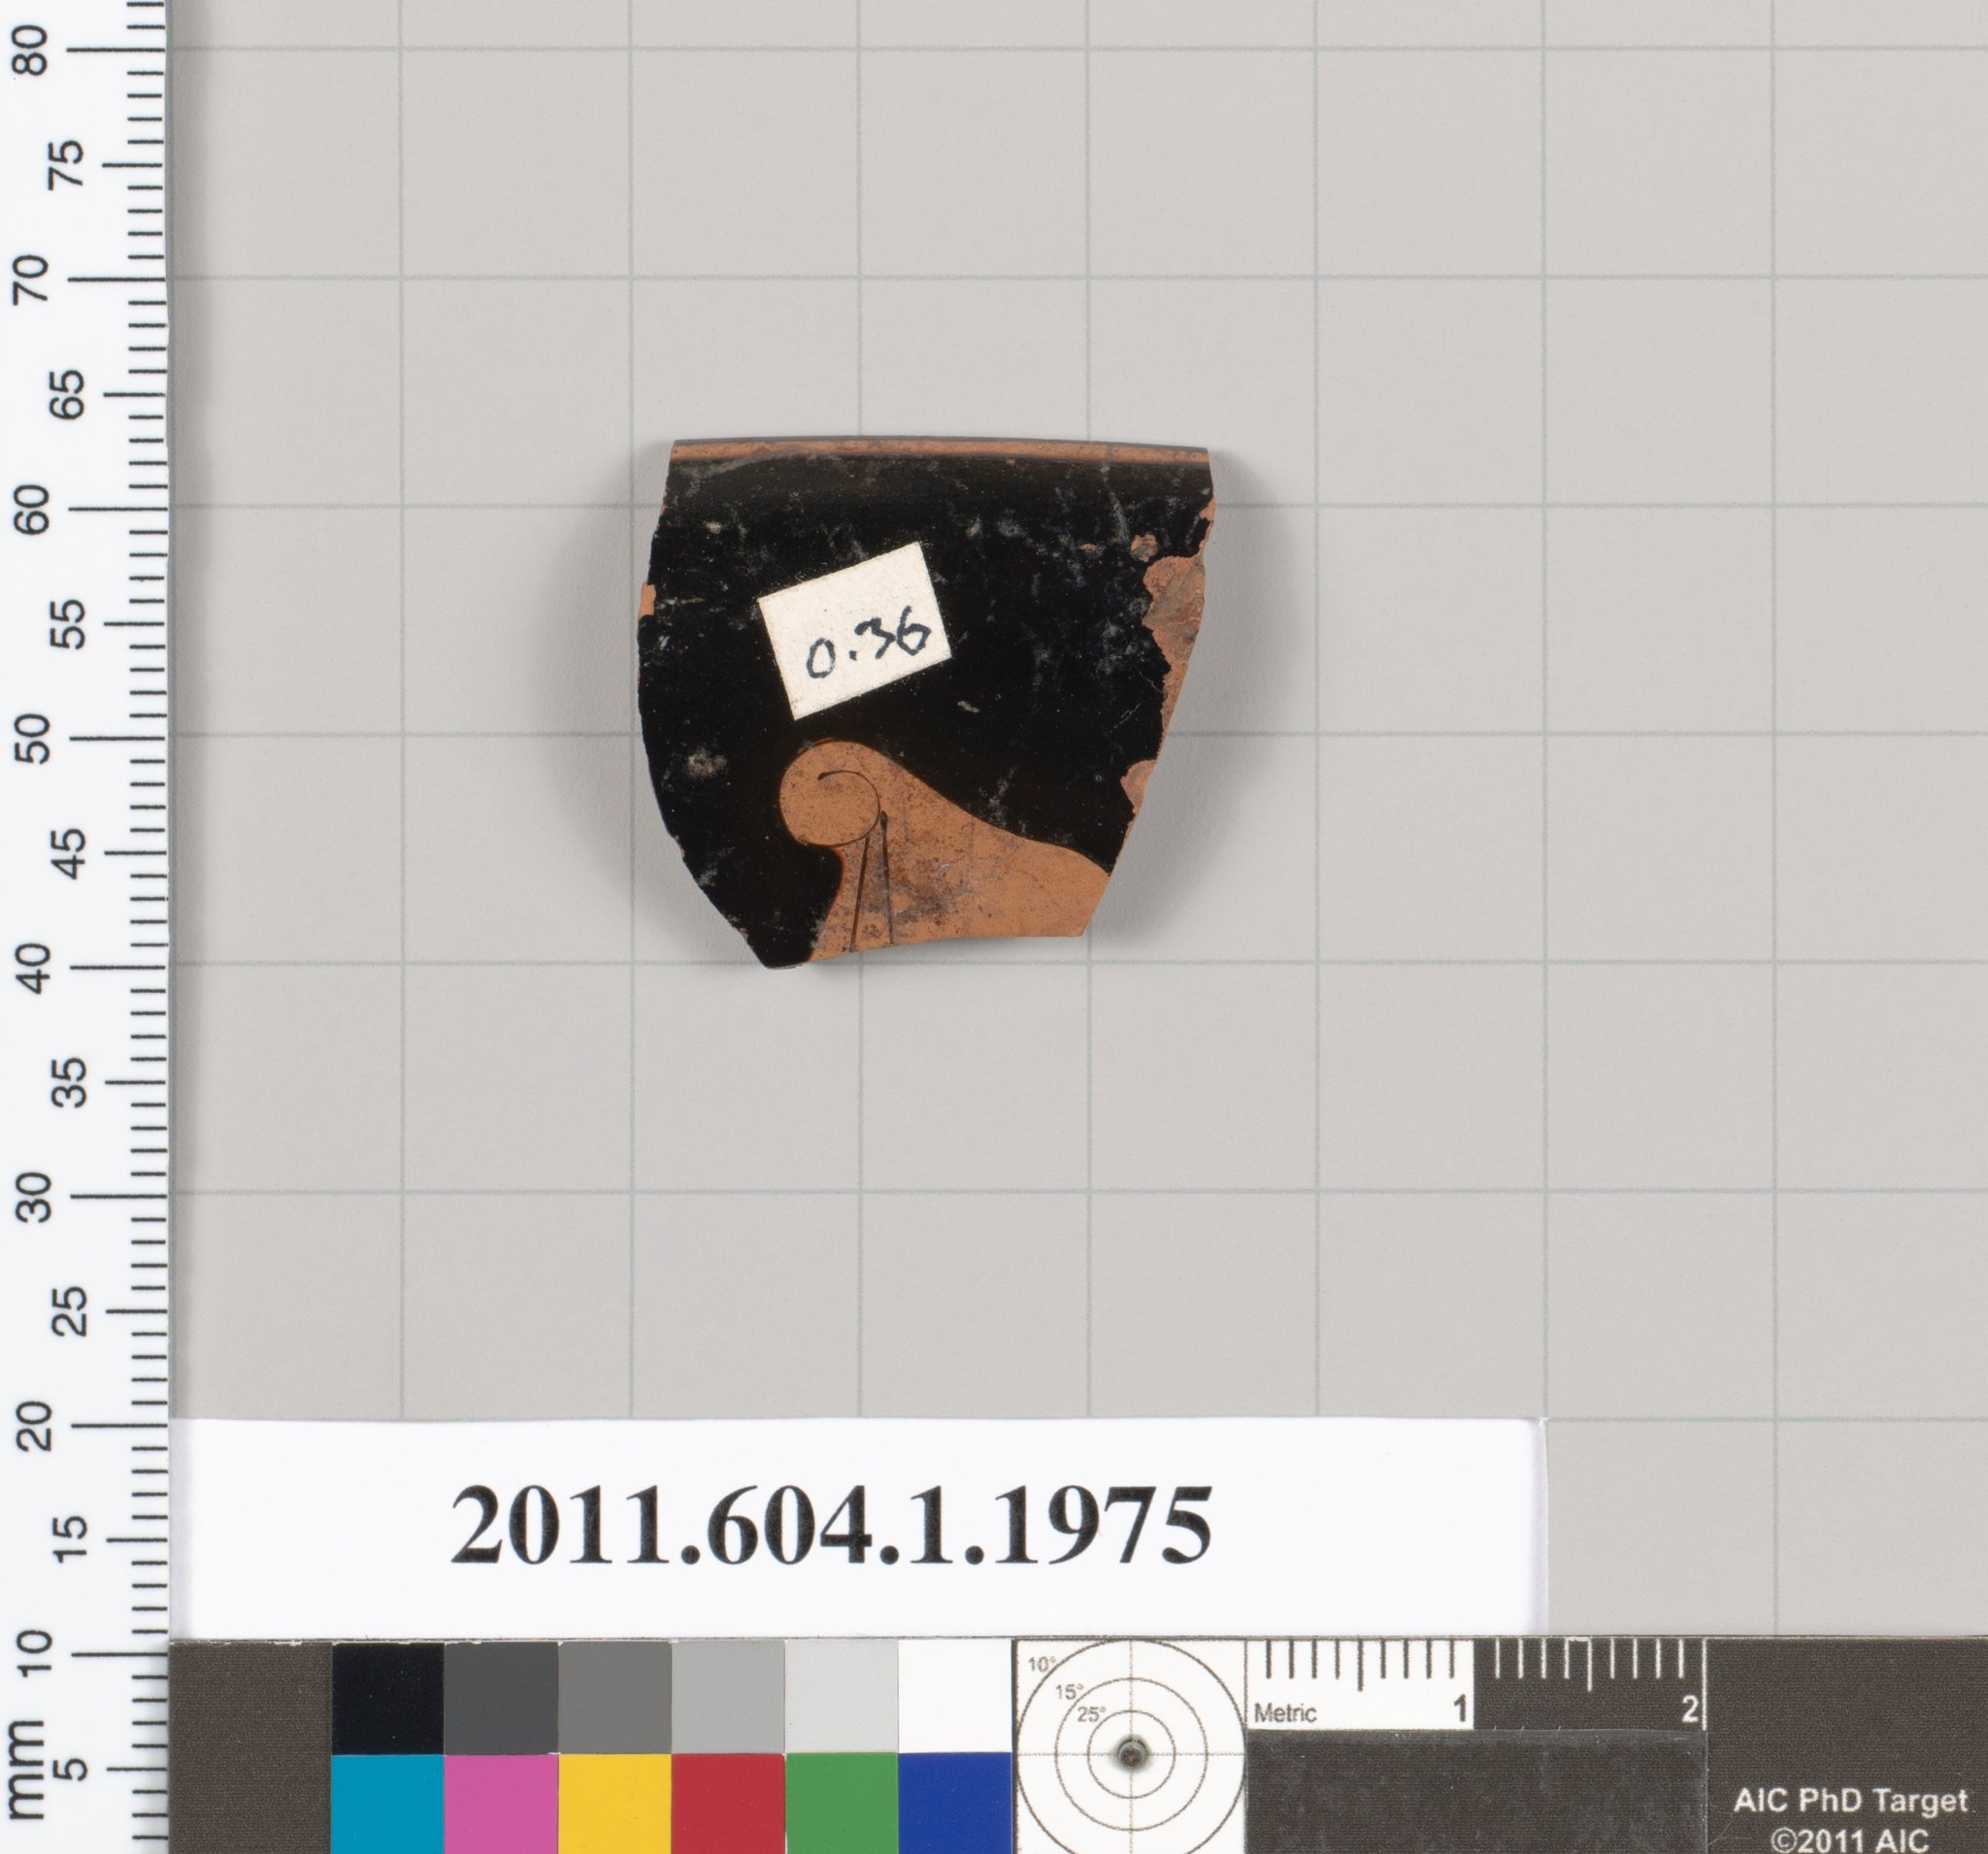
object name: kylix fragment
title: Terracotta rim fragment of a kylix (drinking cup)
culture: greek, attic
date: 475-451 BCE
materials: terracotta